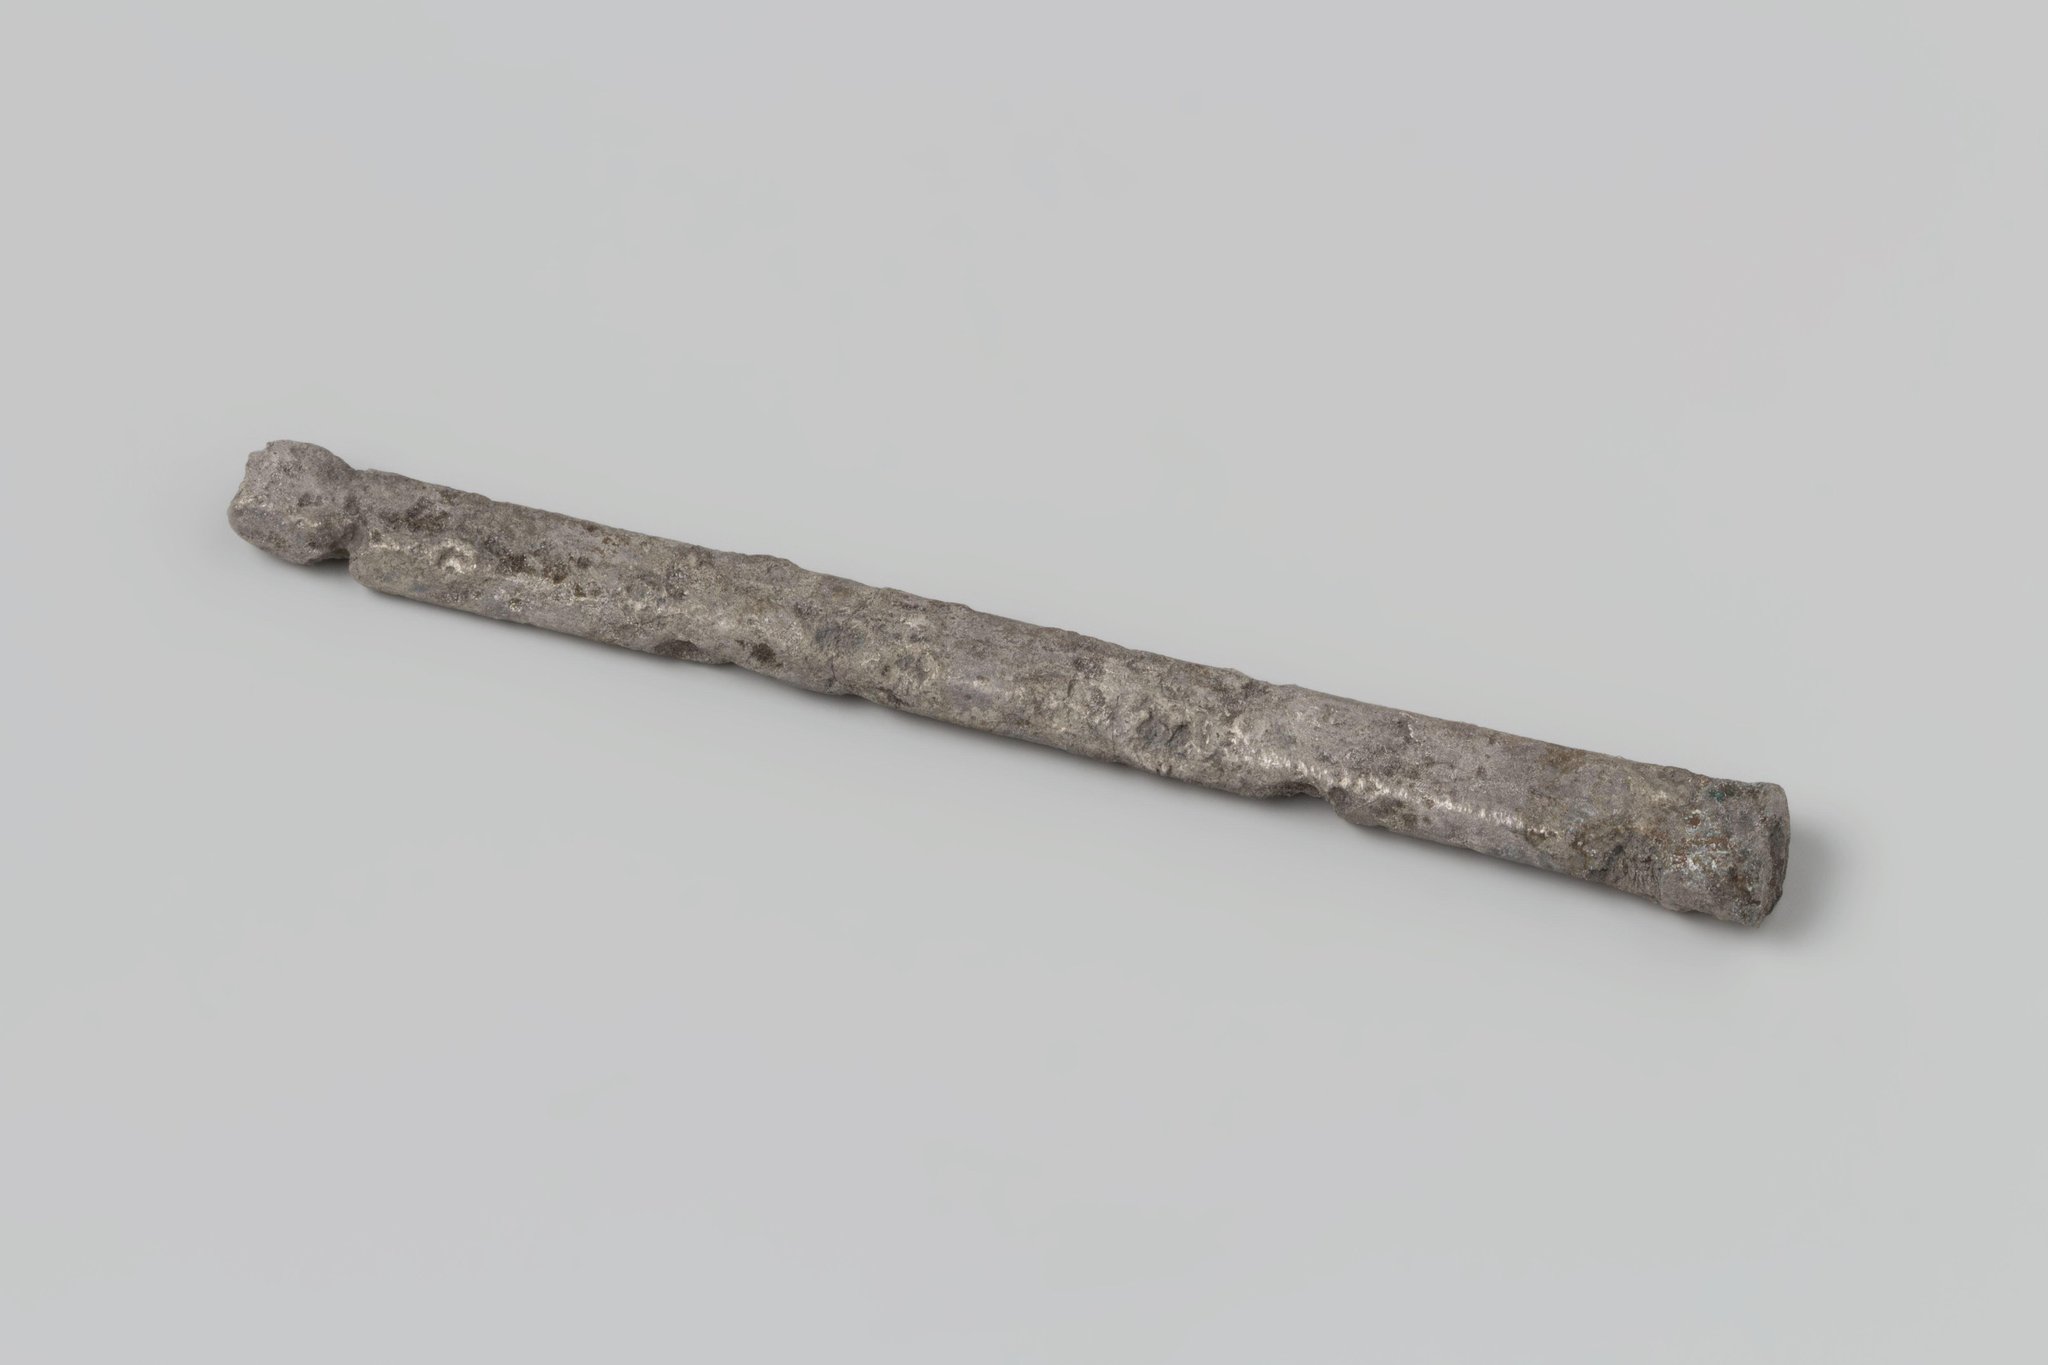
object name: fork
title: Steel van een lepel of vork uit V.O.C.-schip de 'Witte Leeuw'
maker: Anonymous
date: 1613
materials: tin